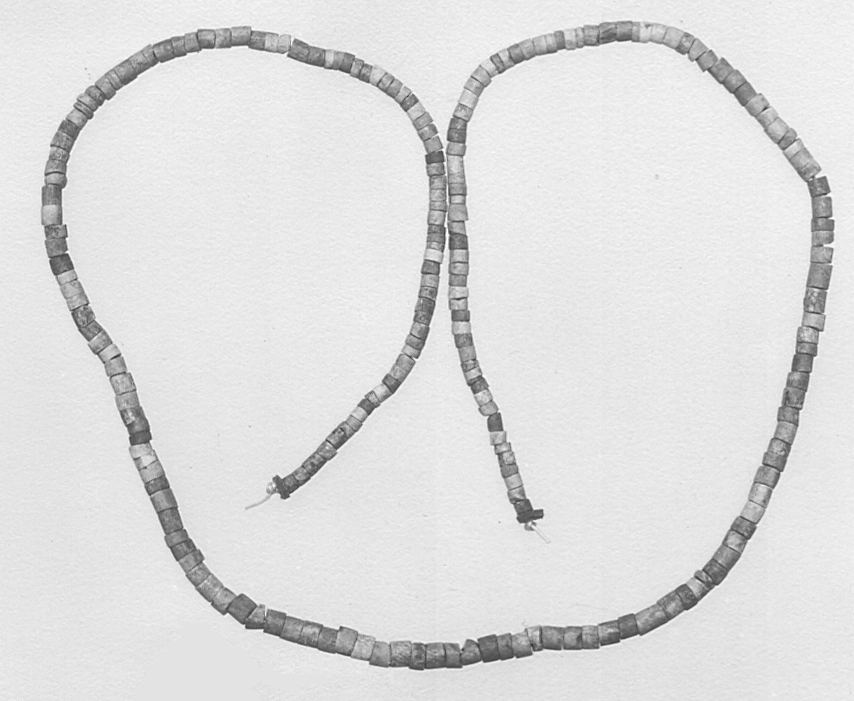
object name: bead, string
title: String of beads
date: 4400-3800 BCE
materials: stone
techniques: glazing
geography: egypt